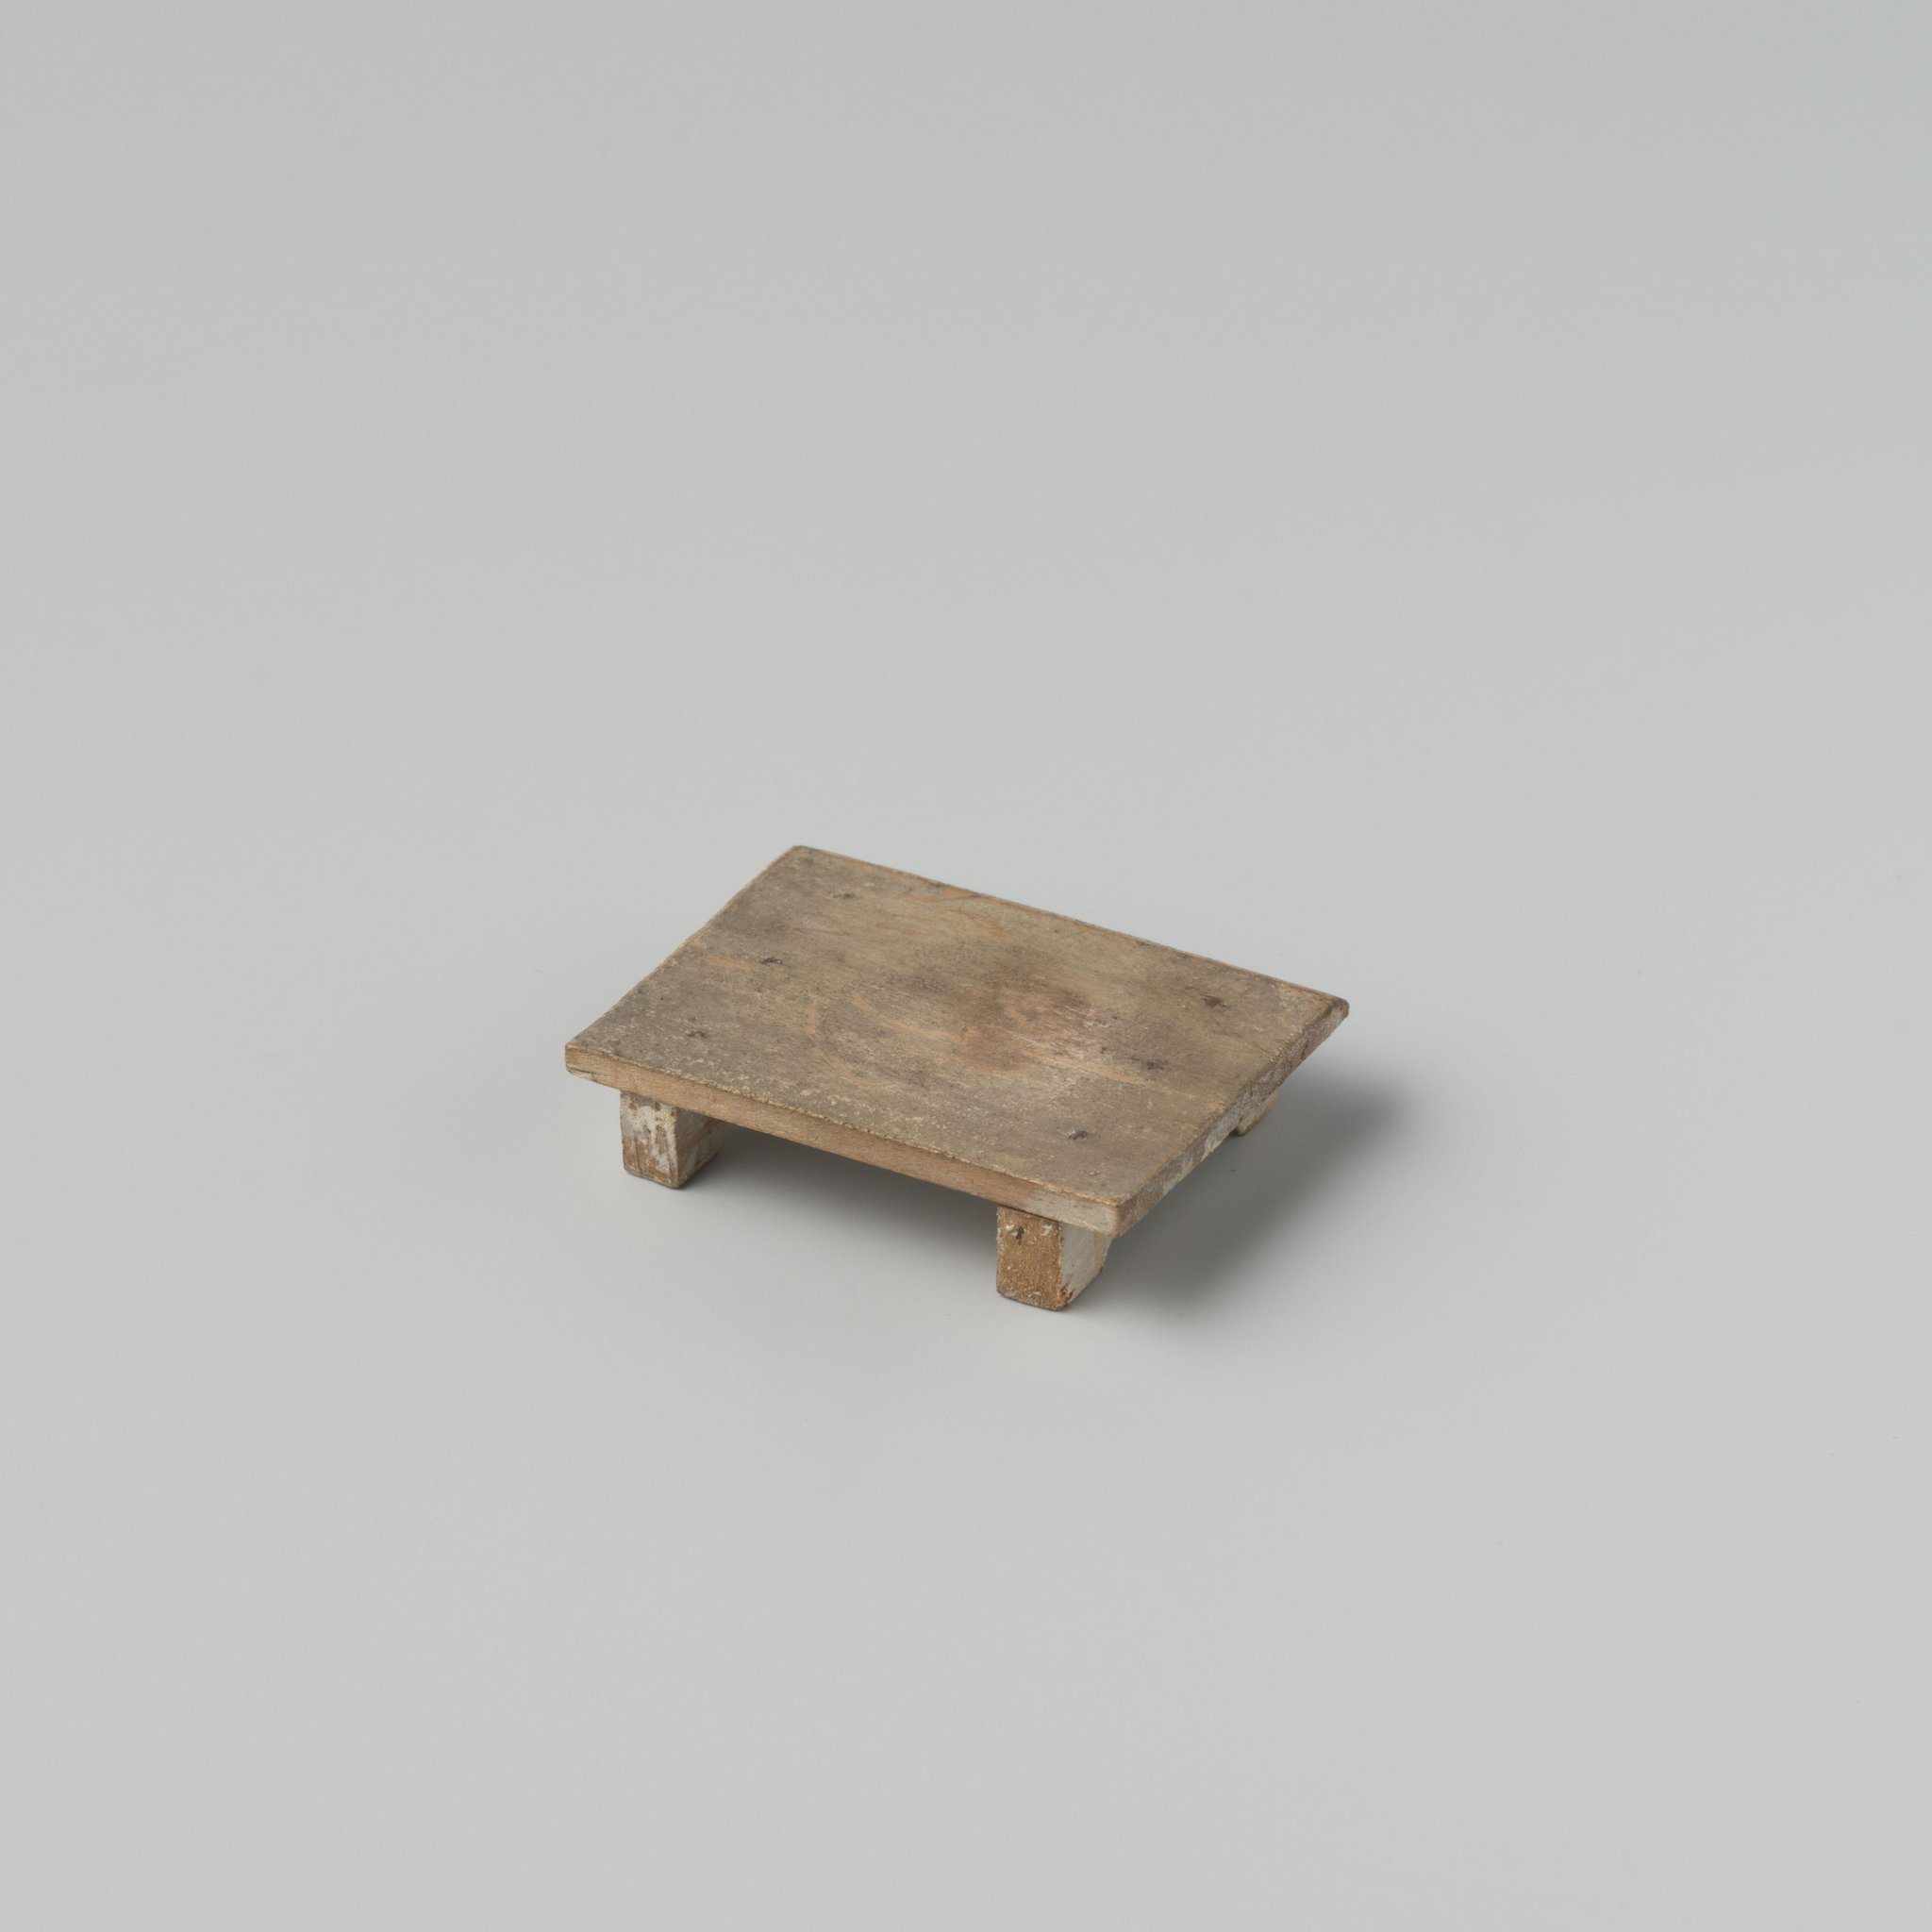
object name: miniature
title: Vlonder of laagbankje van een wit gesausd withoutsoort; bestaande uit alleen aan de voorzijde geprofileerde plank, rustend op twee dwarsplankjes met accolade versiering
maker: Anonymous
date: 1690-1710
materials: wood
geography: amsterdam